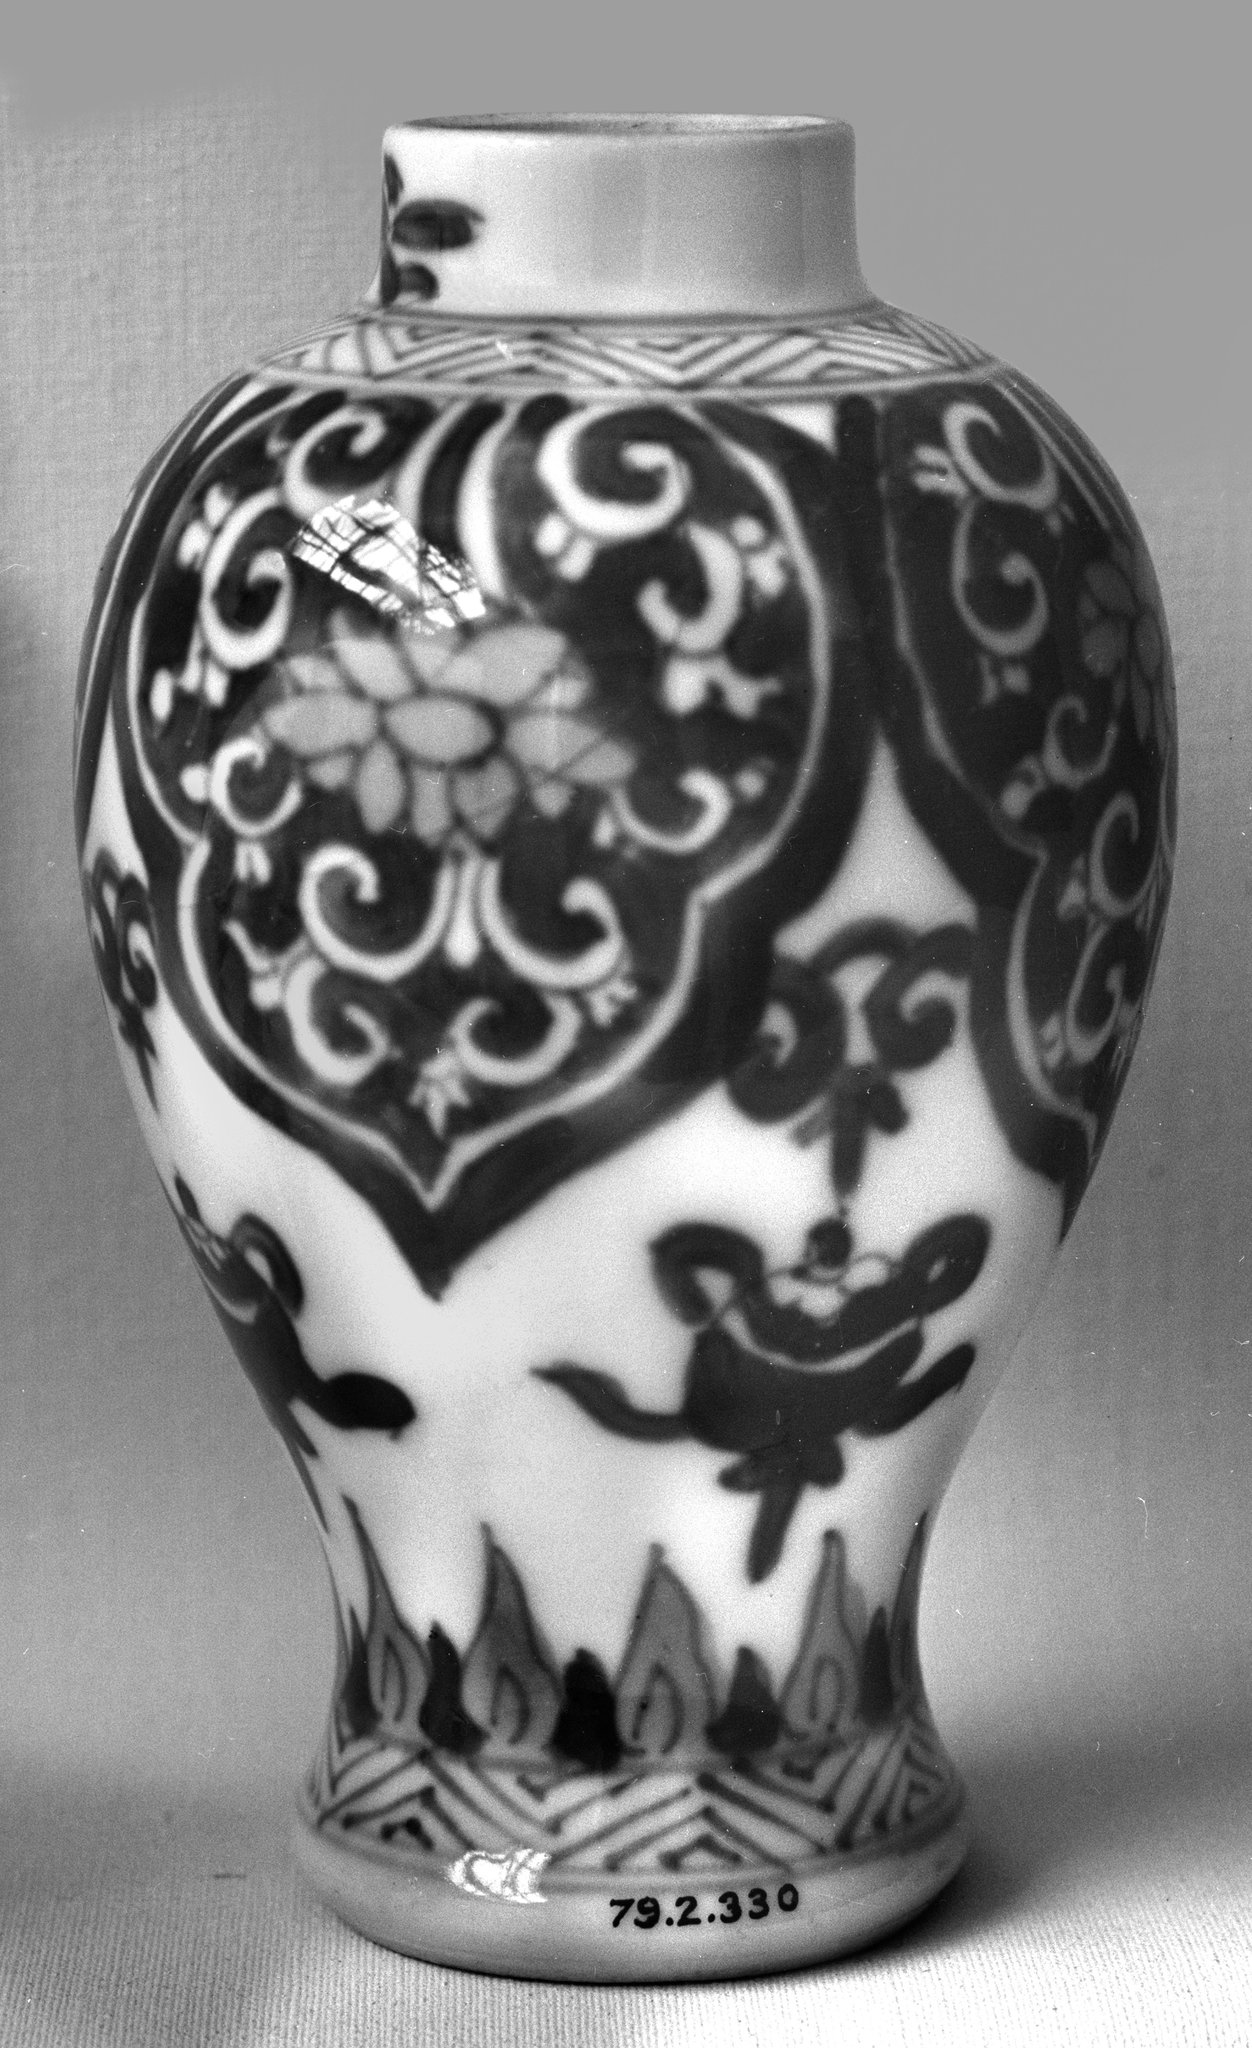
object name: jar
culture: chinese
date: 1662-1722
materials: porcelain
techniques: painting, underglaze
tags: flowers